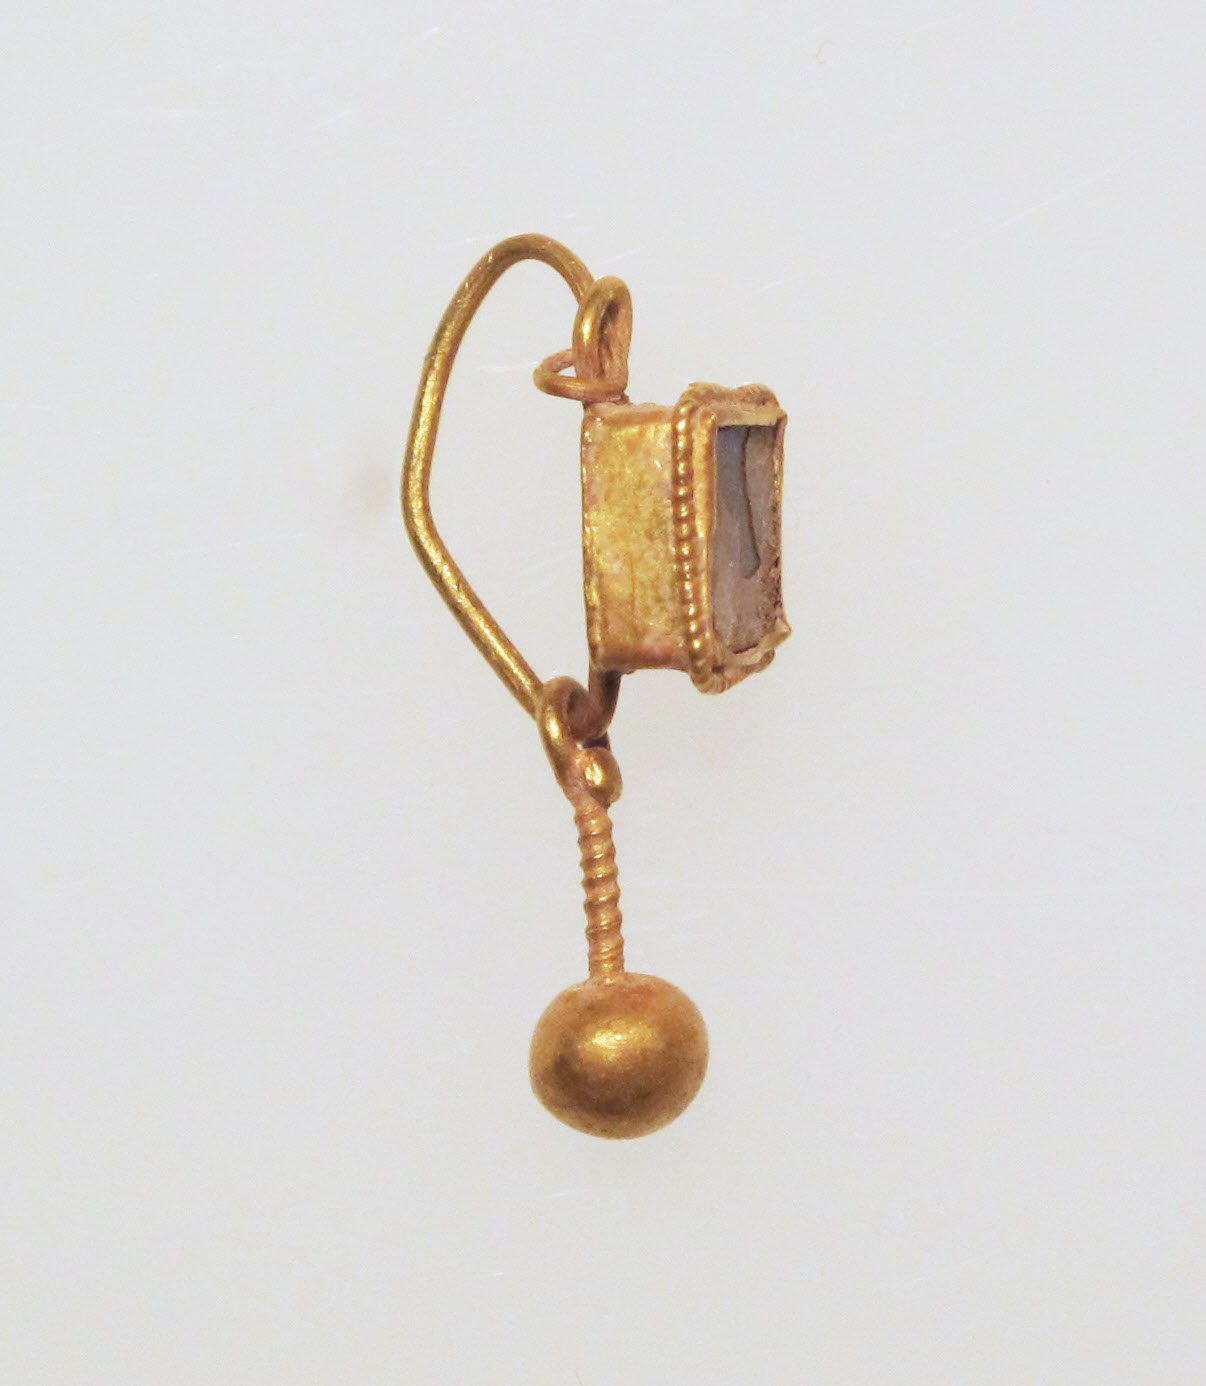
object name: earring hook type with ball pendant and paste setting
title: Earring with ball pendant and paste setting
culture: roman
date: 1-200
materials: glass, gold, paste